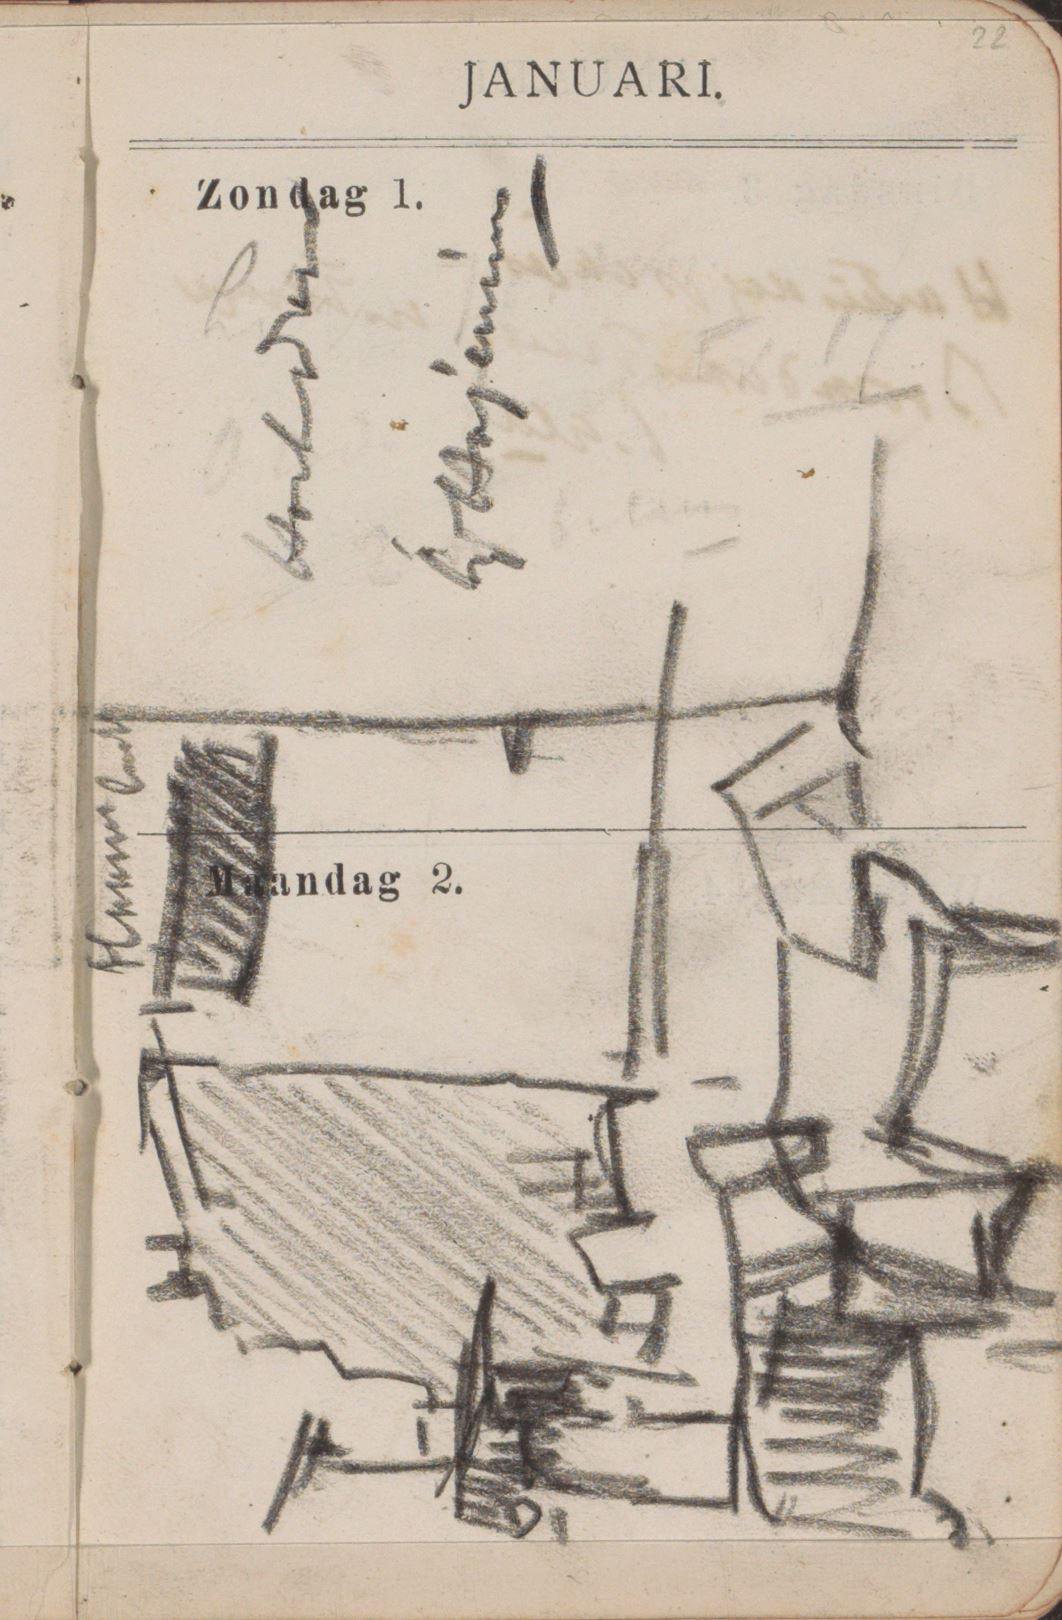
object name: sketchbook leaf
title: Gezicht in Amsterdam, mogelijk de Haarlemmerbuurt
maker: george hendrik breitner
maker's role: draughtsman, painter, print maker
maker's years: 1857-1923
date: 1893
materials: chalk, paper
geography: amsterdam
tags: horse, civic architecture; edifices; dwellings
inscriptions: annotation: ‘Haarlem[?]/ buurt[?]/ Hoek[?] Dam[?]/ G. Hajenius’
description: Vooraan twee paarden. Pagina 22 uit een als schetsboek gebruikte agenda met 108 bladen.